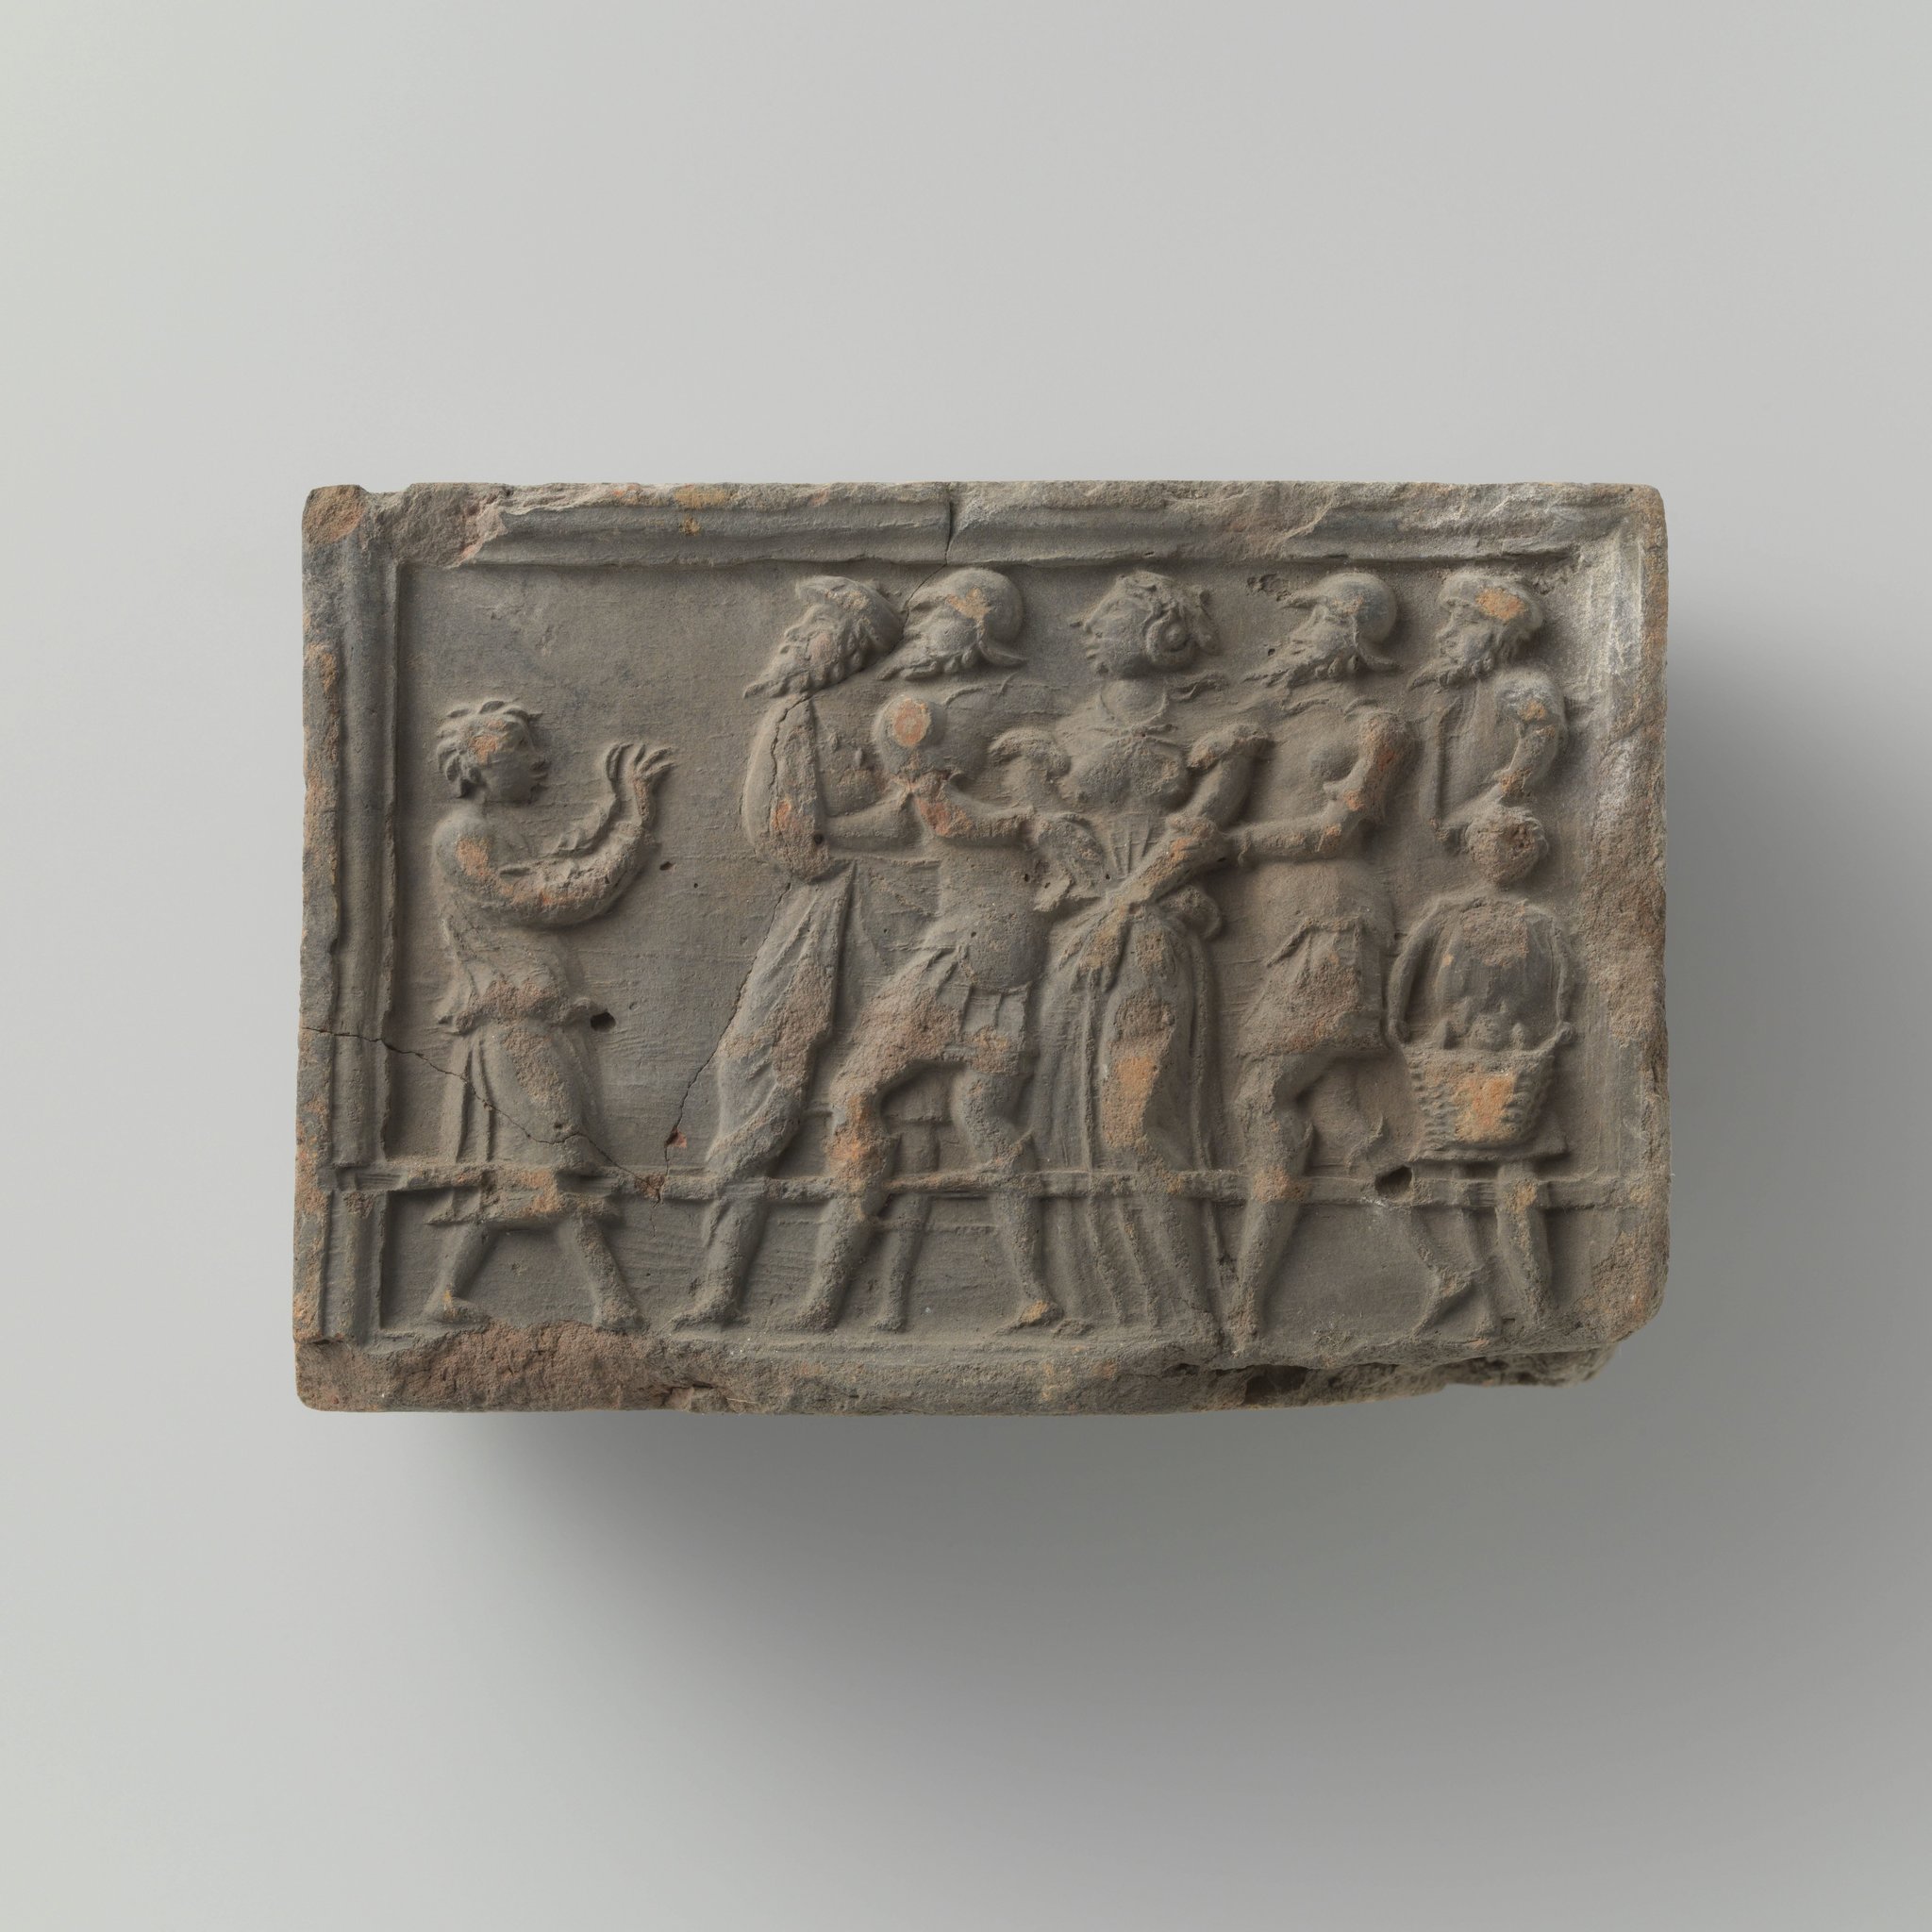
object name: hearthstone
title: Haardsteen met voorstelling van Suzanna, die door de twee ouderlingen voor de rechter wordt gevoerd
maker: Anonymous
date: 1400-1950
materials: earthenware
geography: southern netherlands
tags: the elders accusing susanna before the people, laying their hands on her head or unveiling her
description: Haardsteen met voorstelling van Suzanna, die door de twee ouderlingen voor de rechter wordt gevoerd.